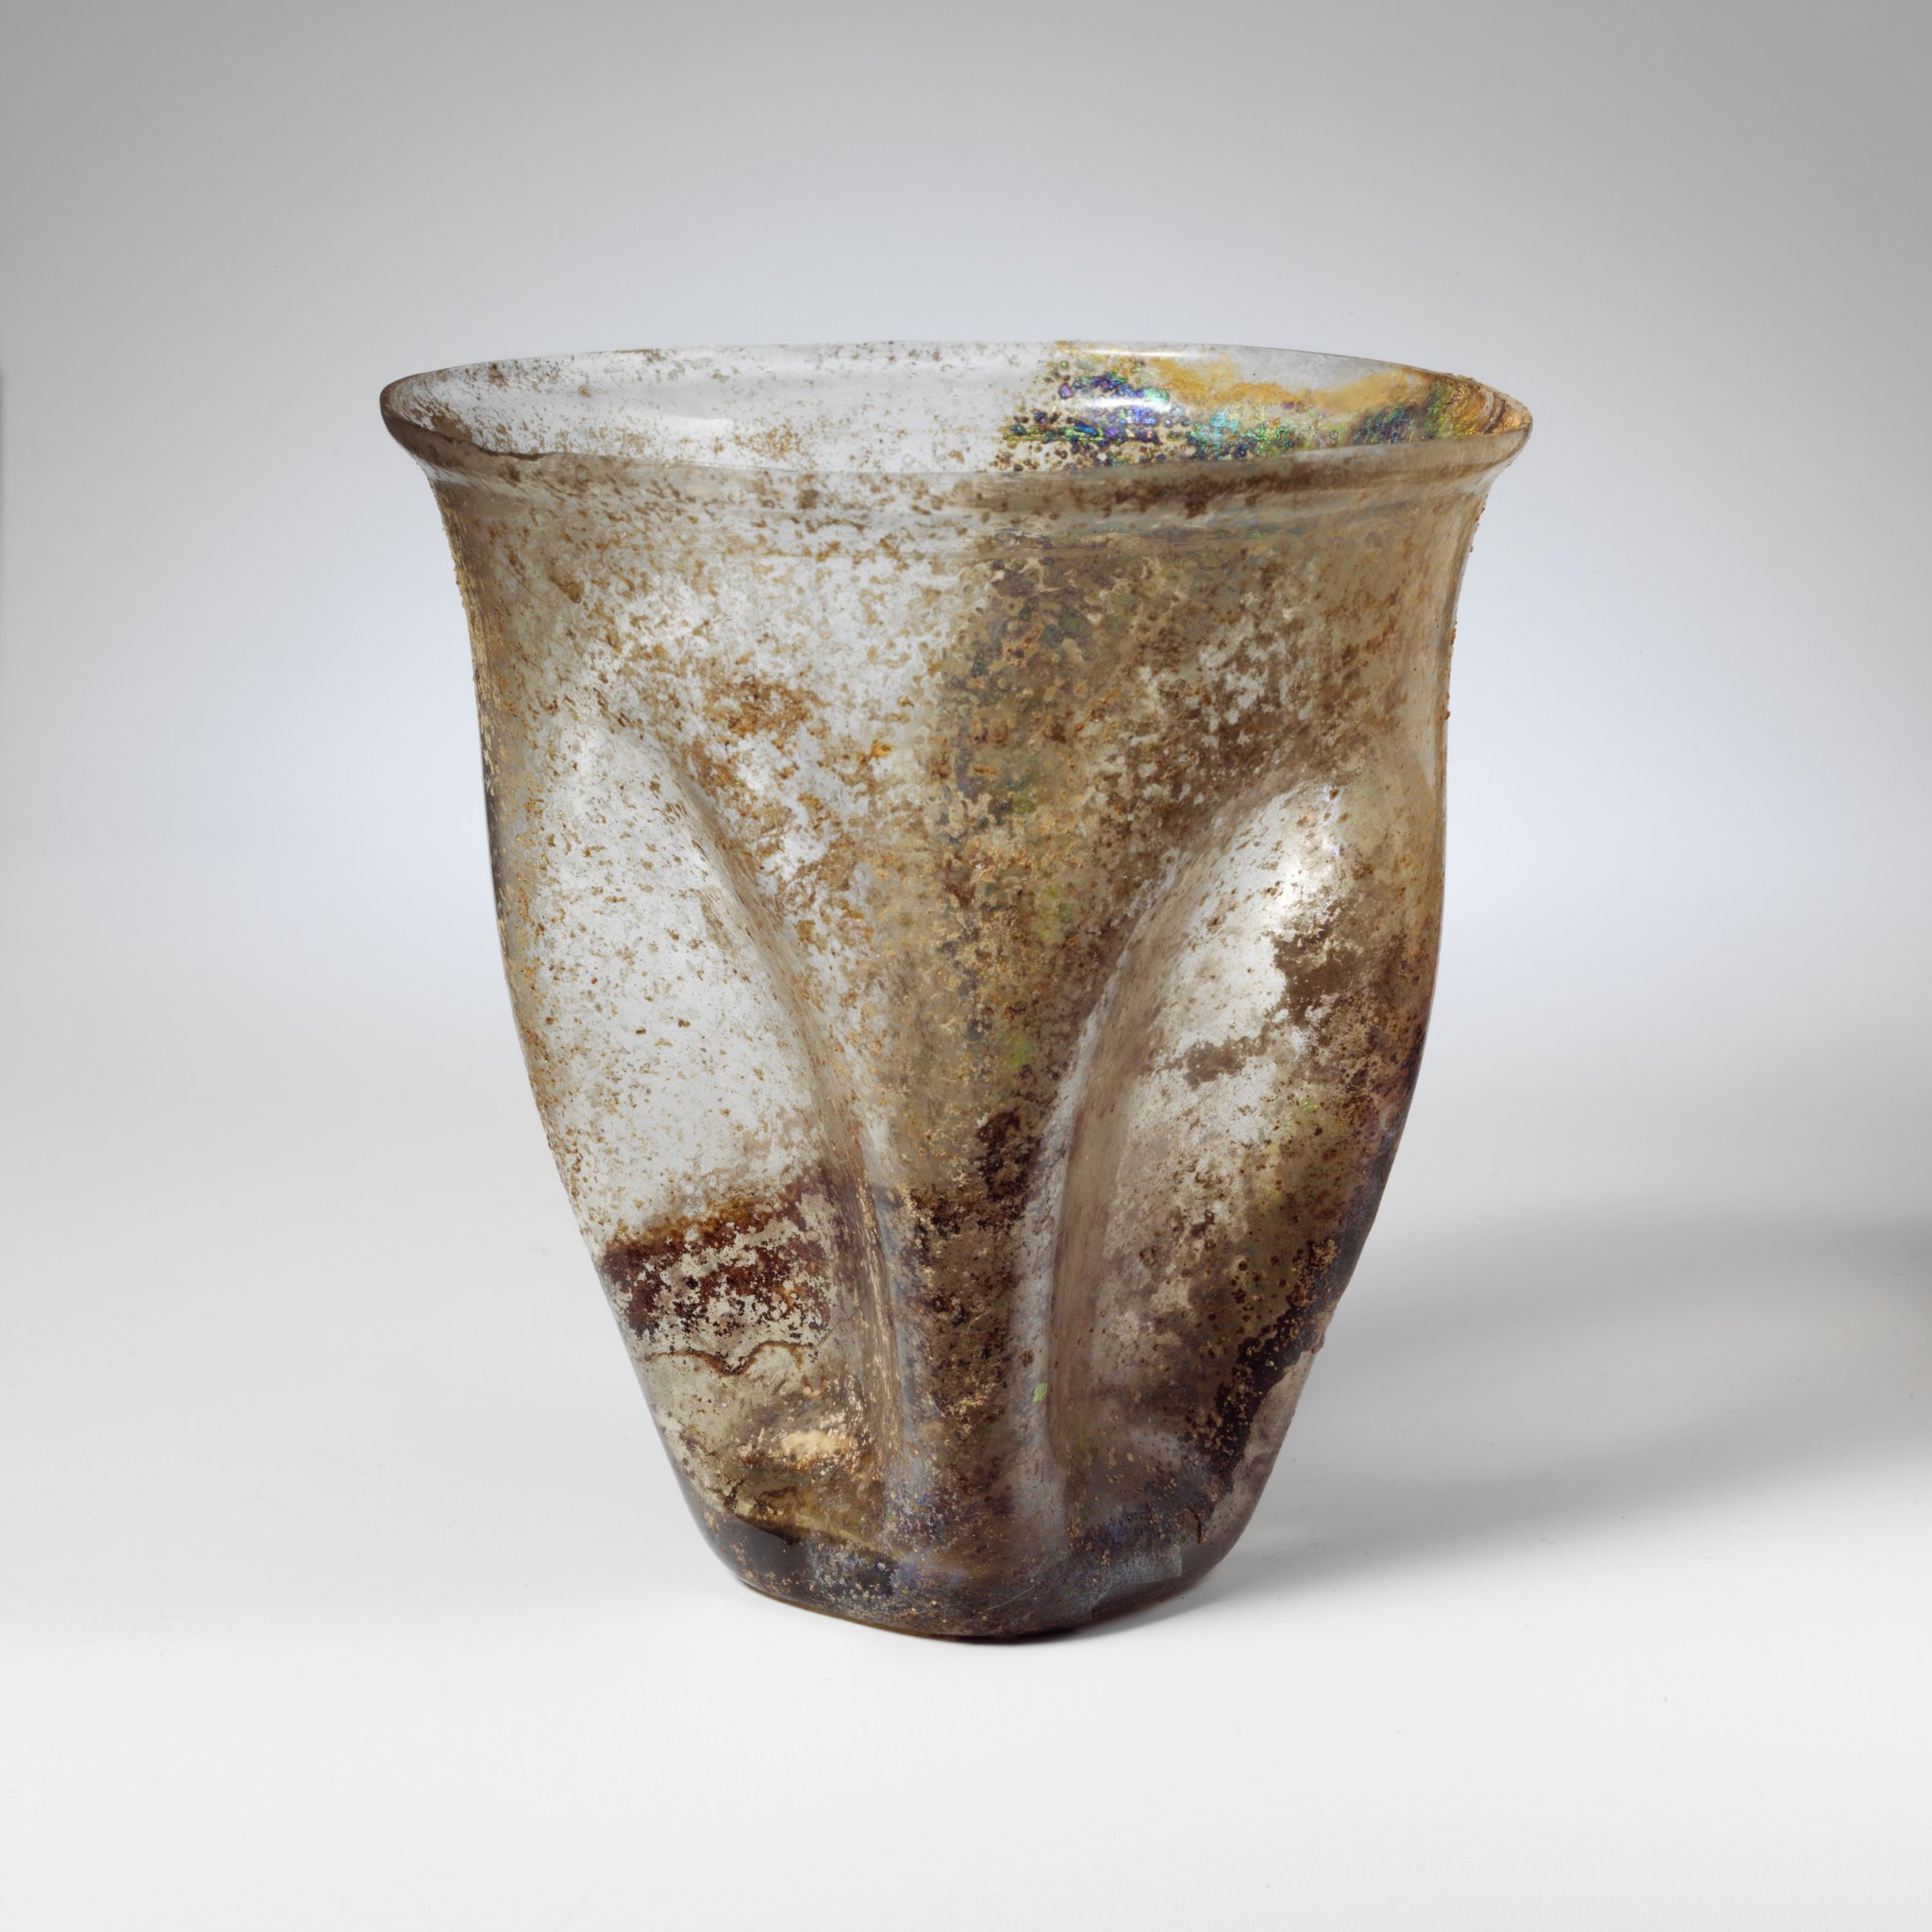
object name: beaker, indented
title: Glass beaker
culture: roman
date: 101-300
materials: glass